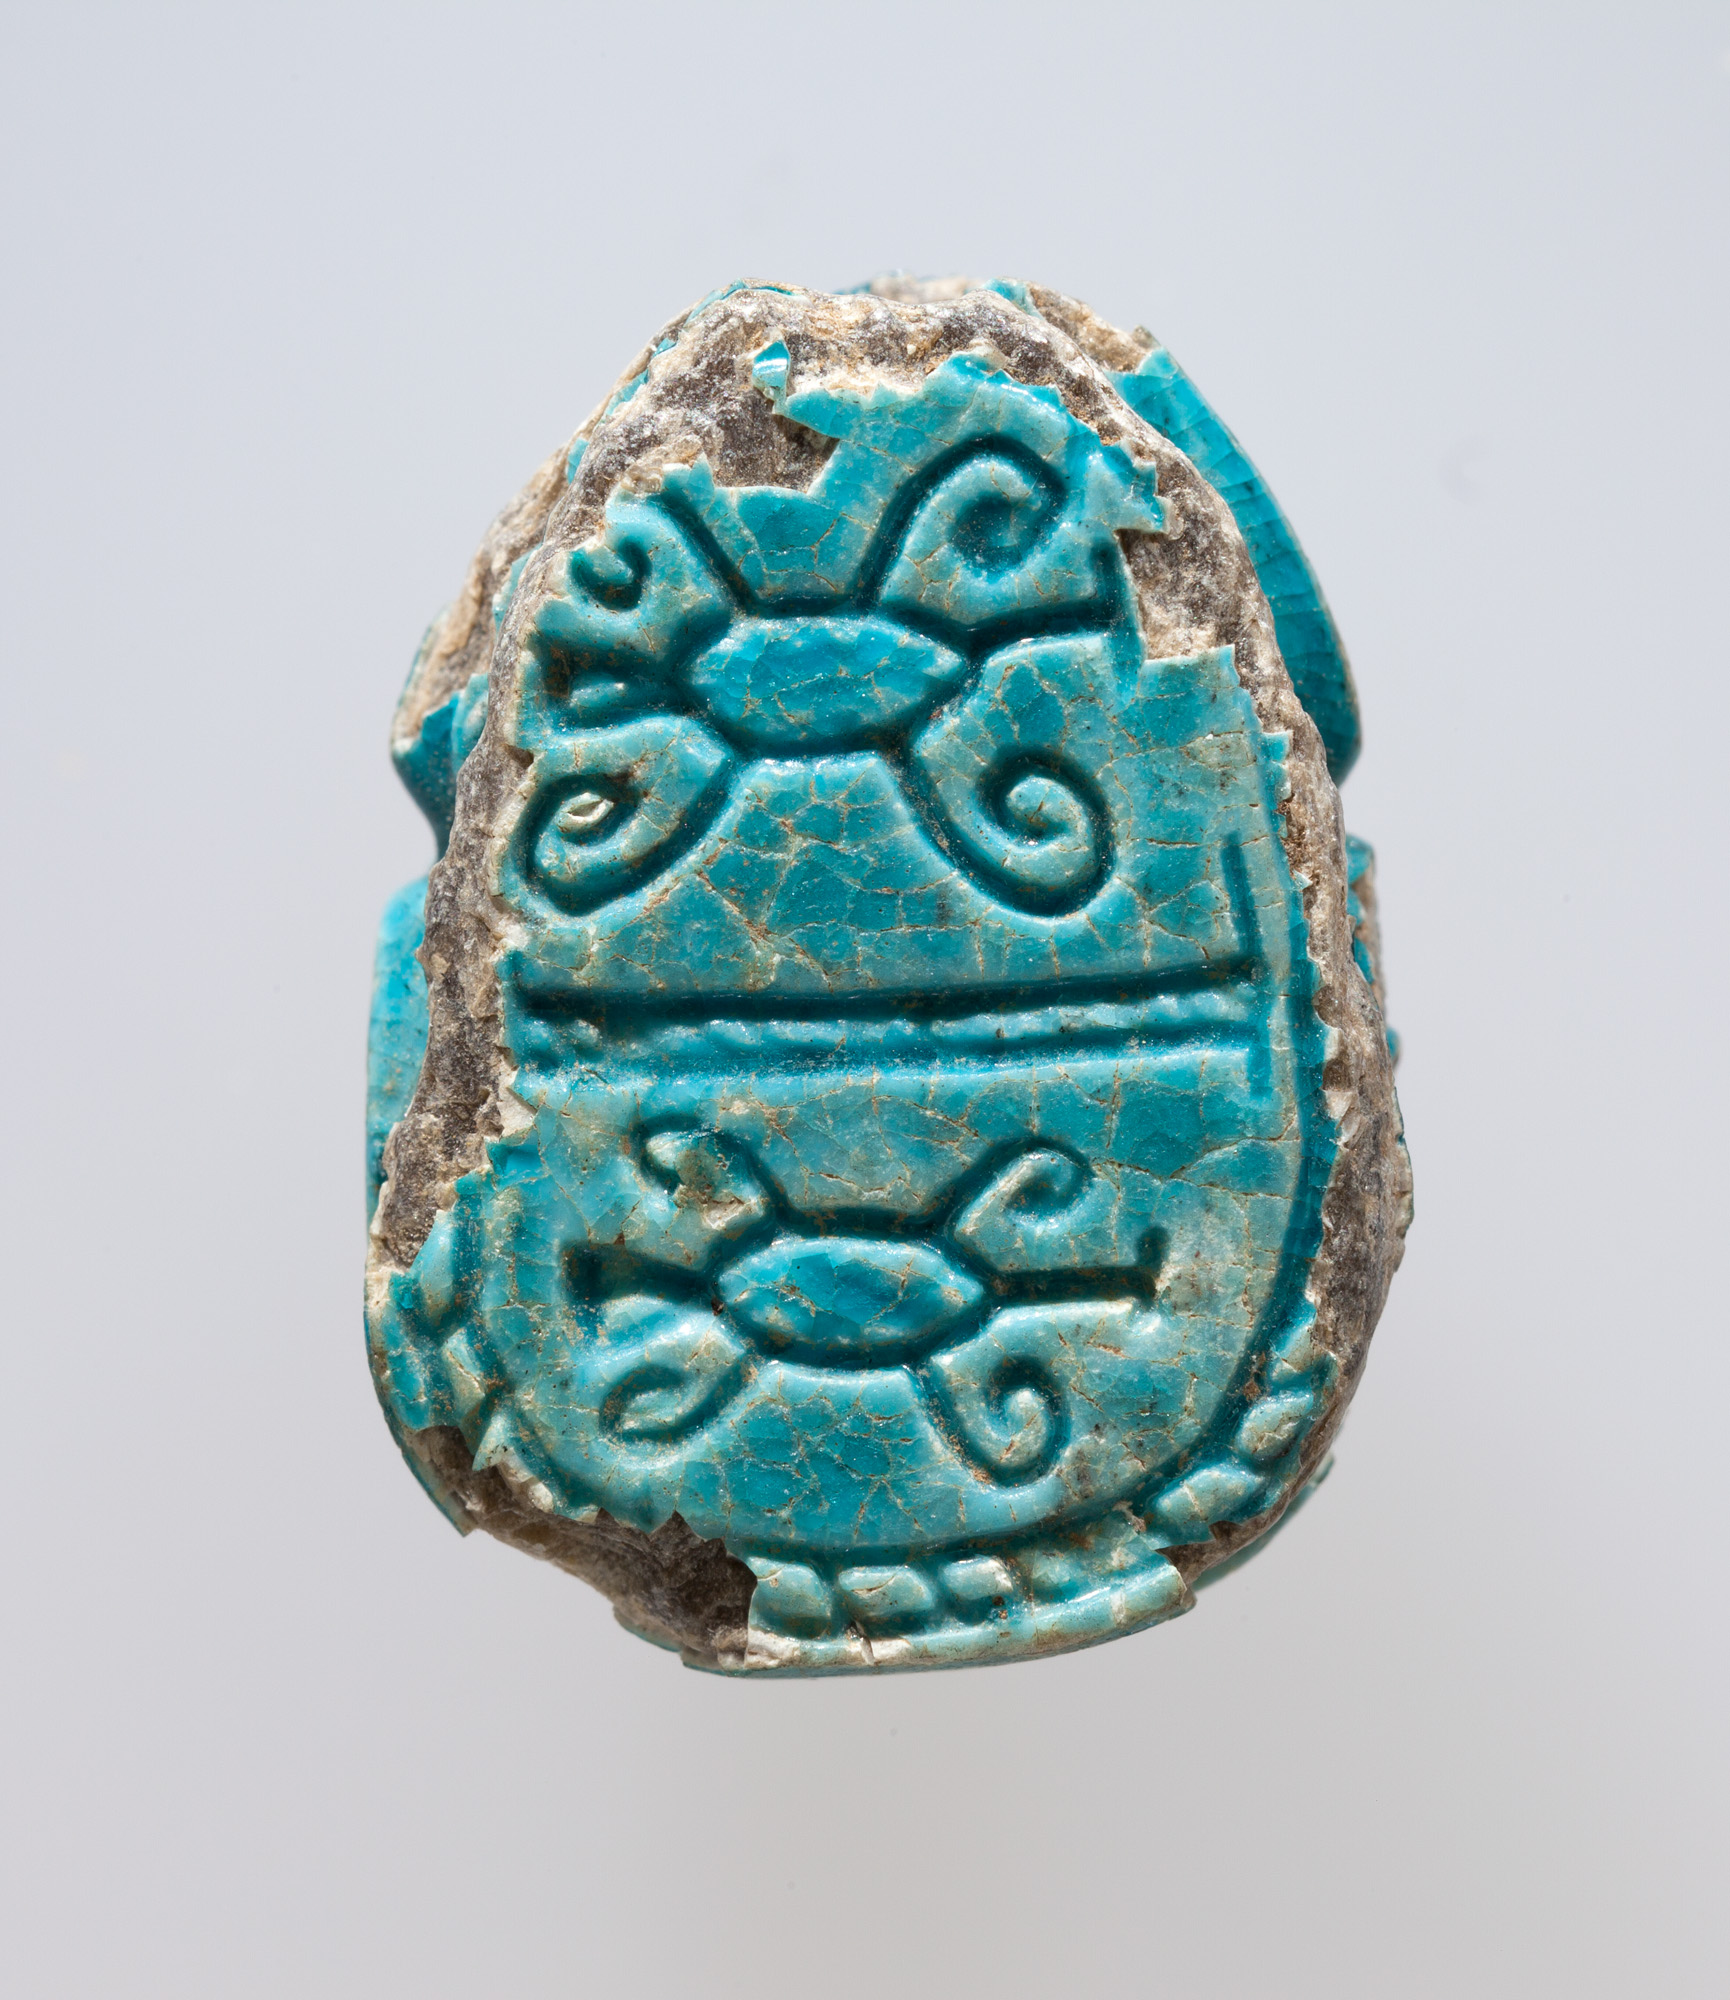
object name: scarab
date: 1479-1458 BCE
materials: faience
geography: egypt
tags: scarabs